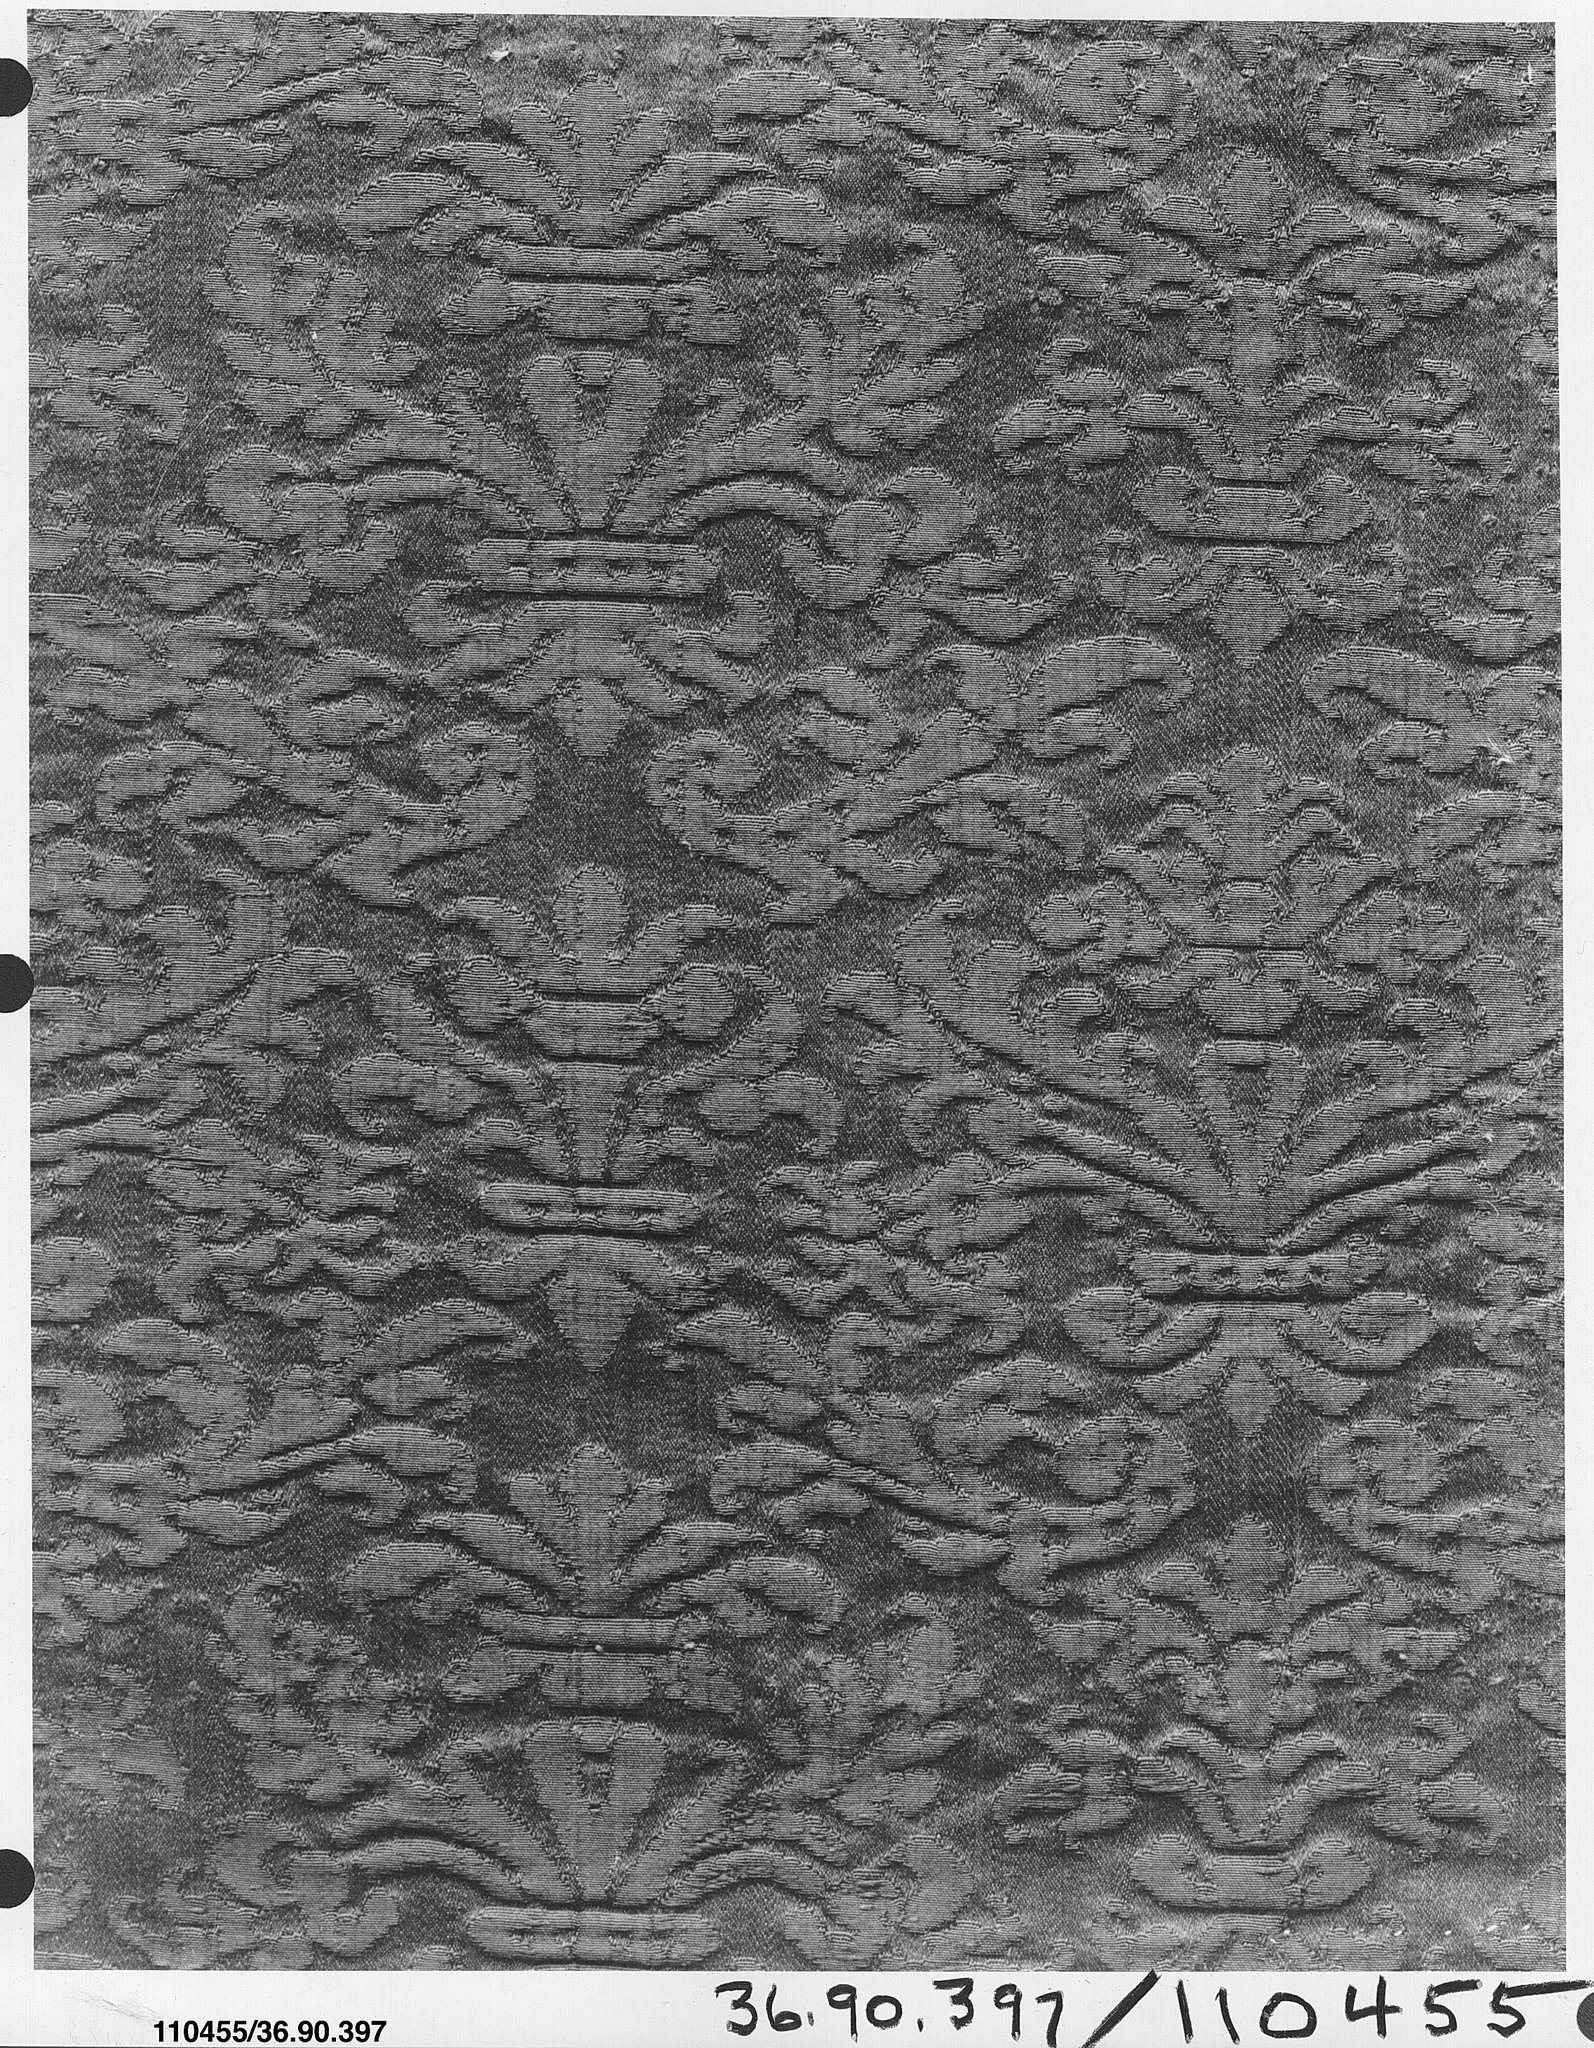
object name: piece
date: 1501-1700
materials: silk